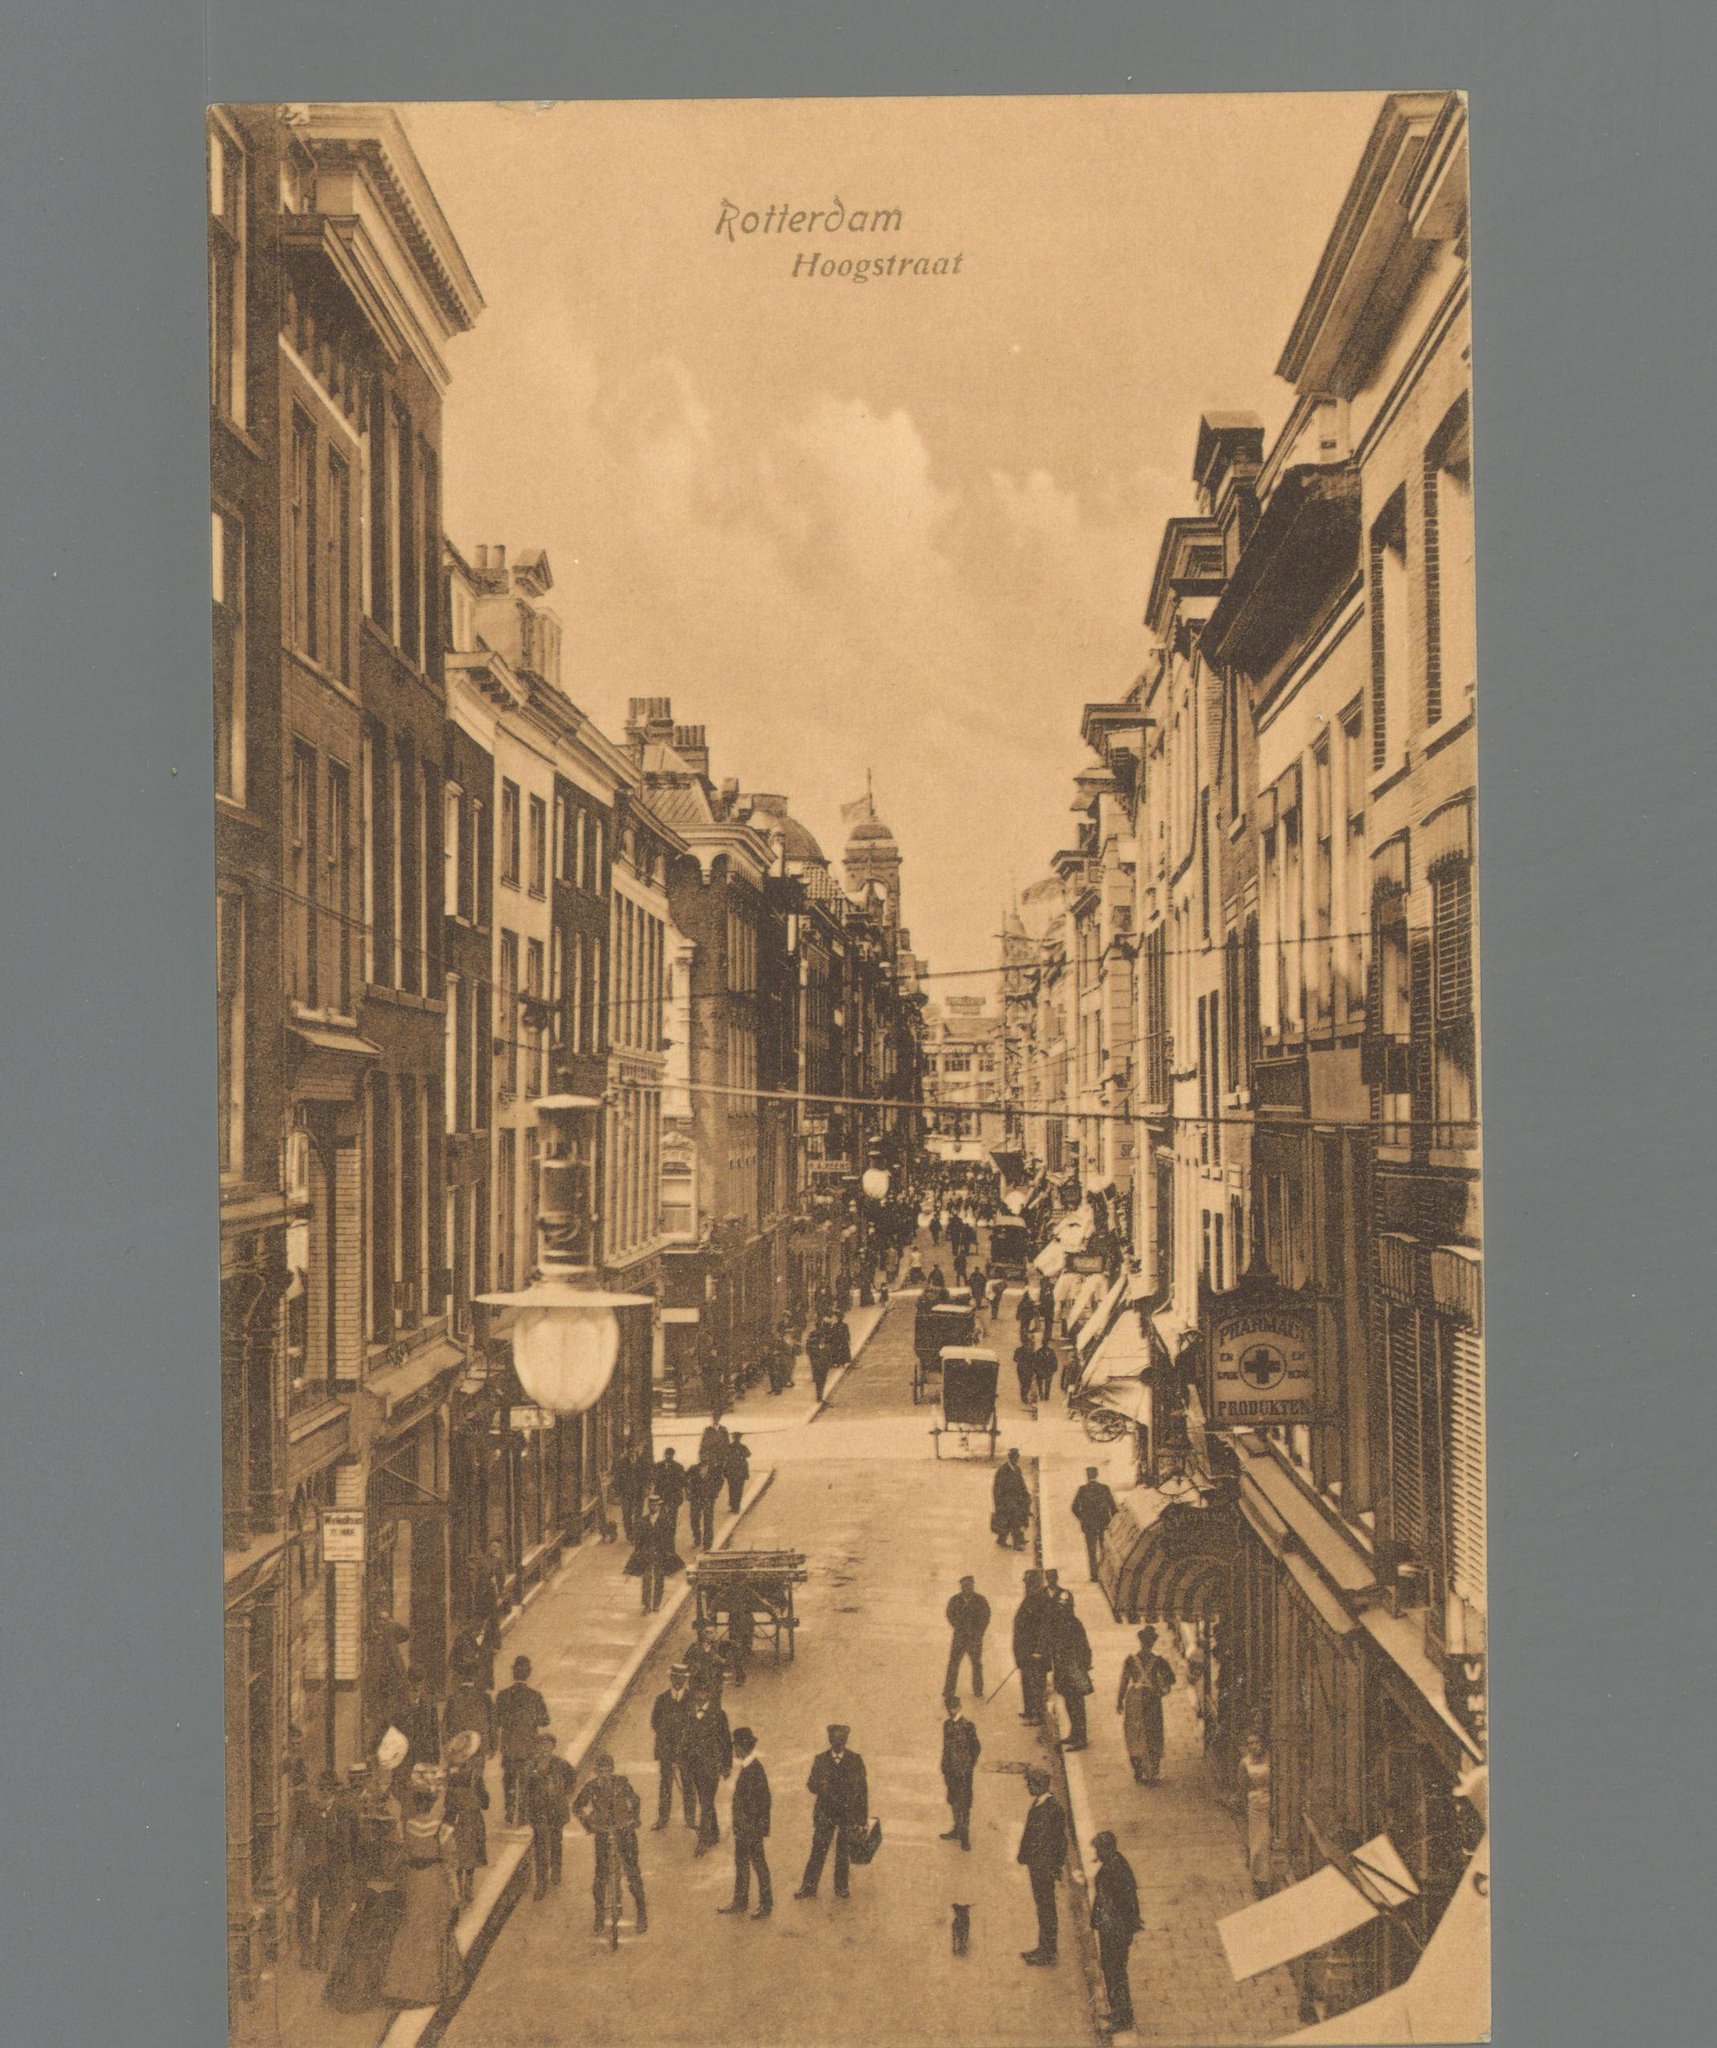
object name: ansichtkaart, prentbriefkaart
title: Rotterdam. Hoogstraat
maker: Anonymous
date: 1910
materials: cardboard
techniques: photograph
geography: the hague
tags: shop, store, street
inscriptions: date